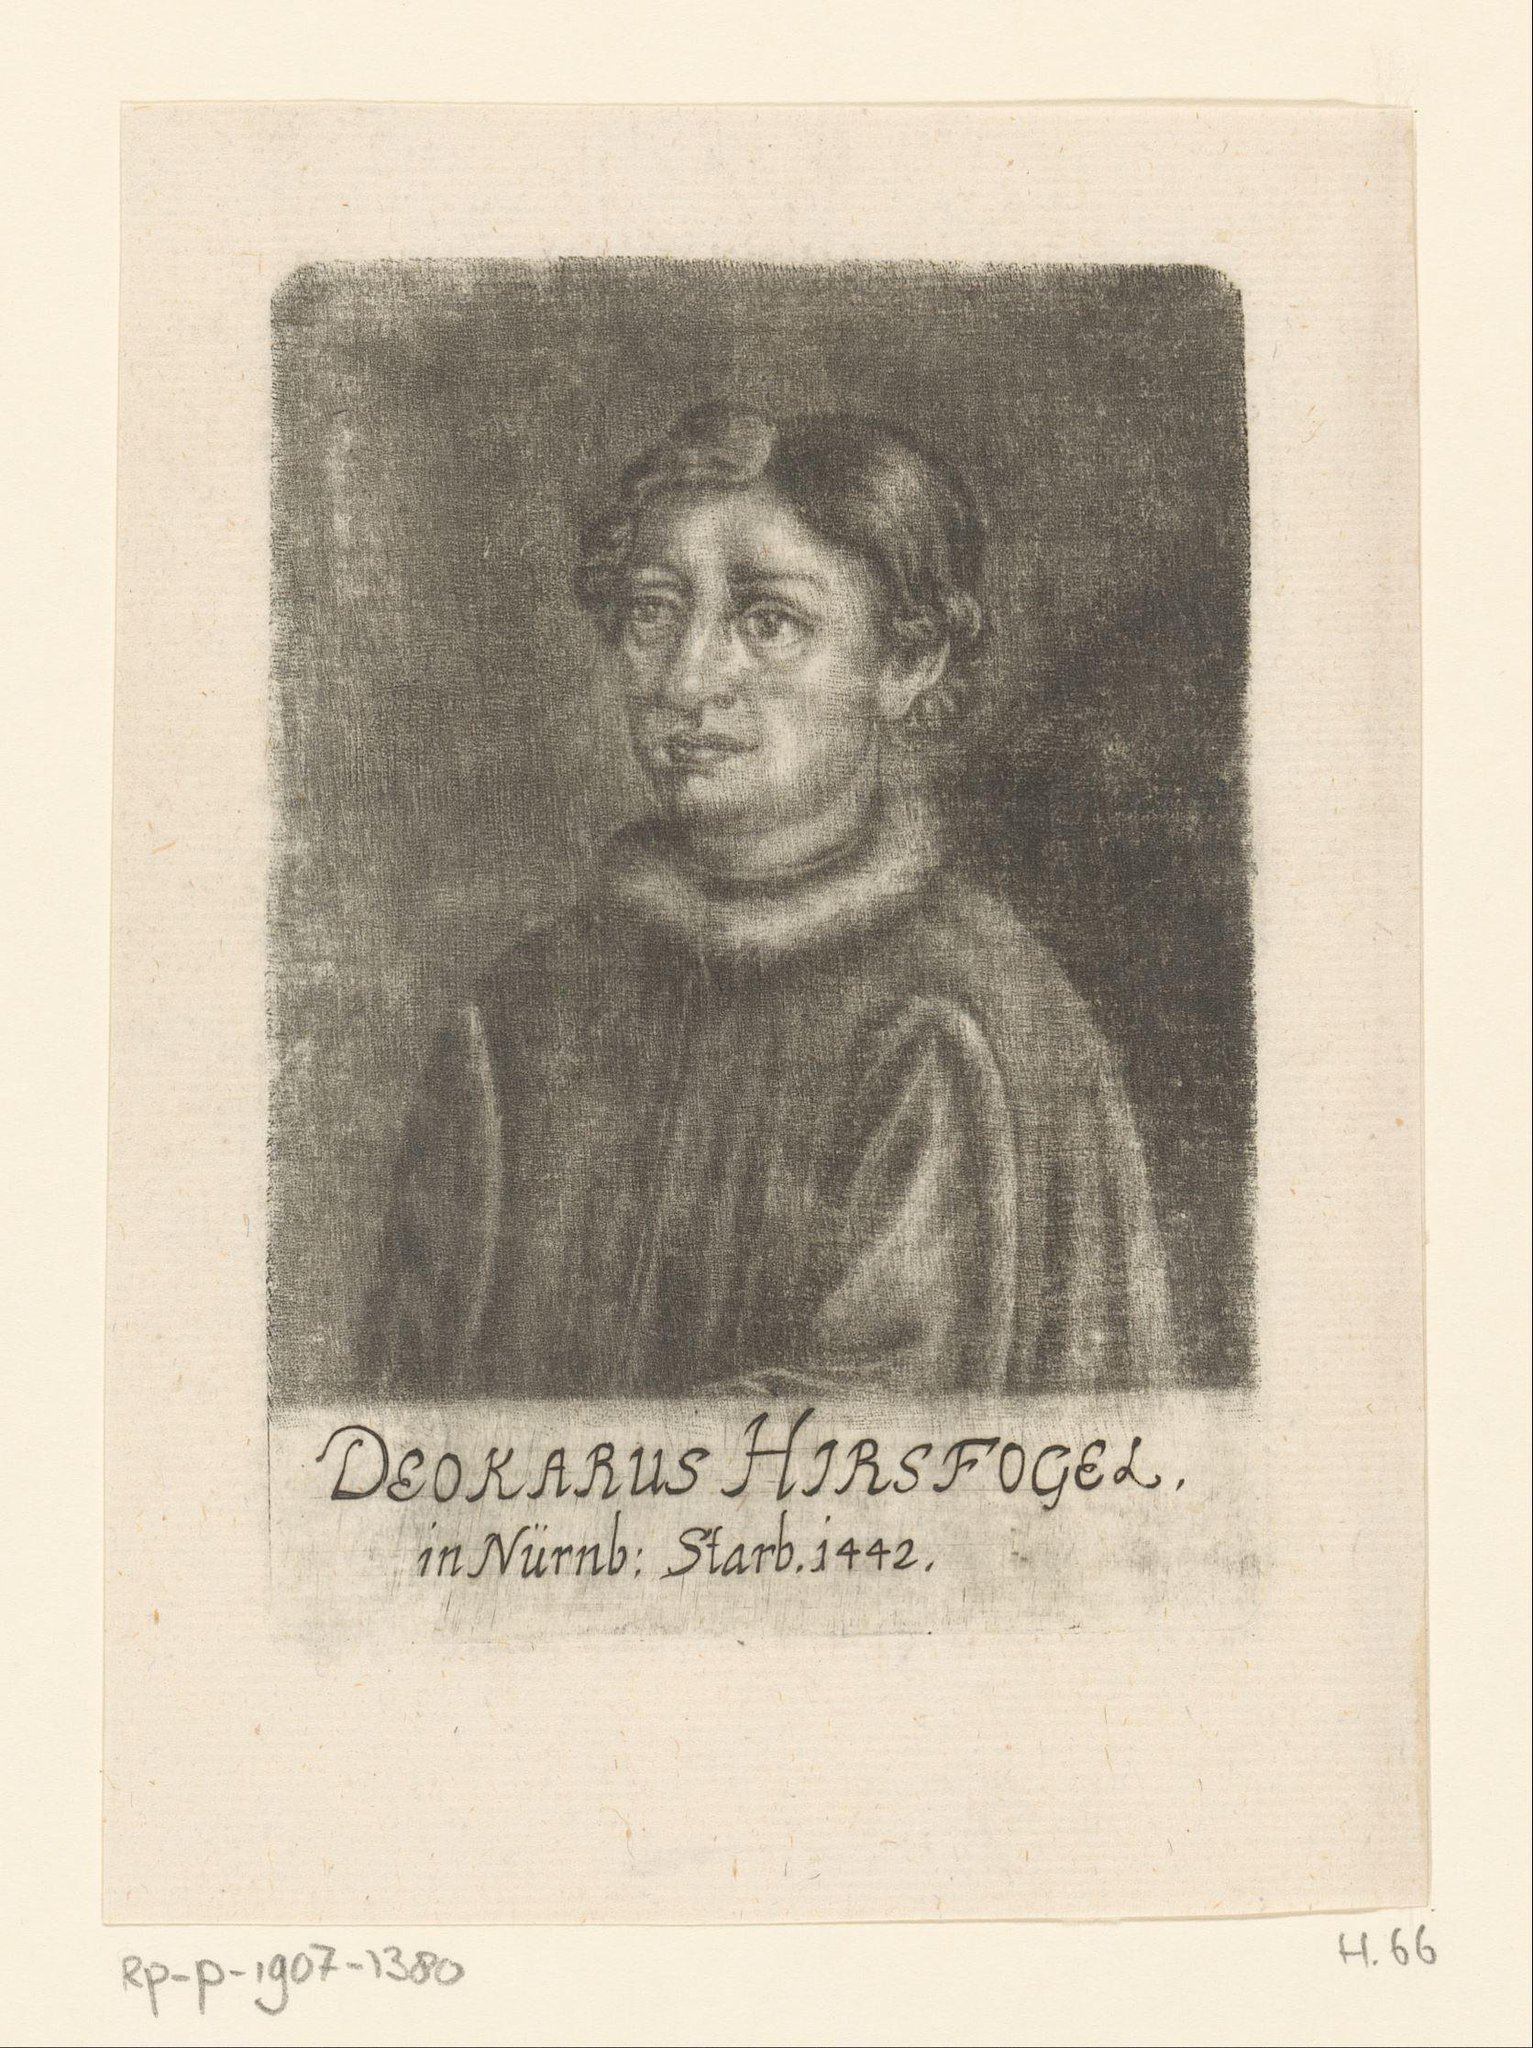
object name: print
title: Portret van Deocarus Hirschvogel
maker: georg fennitzer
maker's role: print maker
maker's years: 1646-1722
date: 1656-1722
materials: paper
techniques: mezzotint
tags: historical persons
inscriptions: collector's mark: Lugt 2228